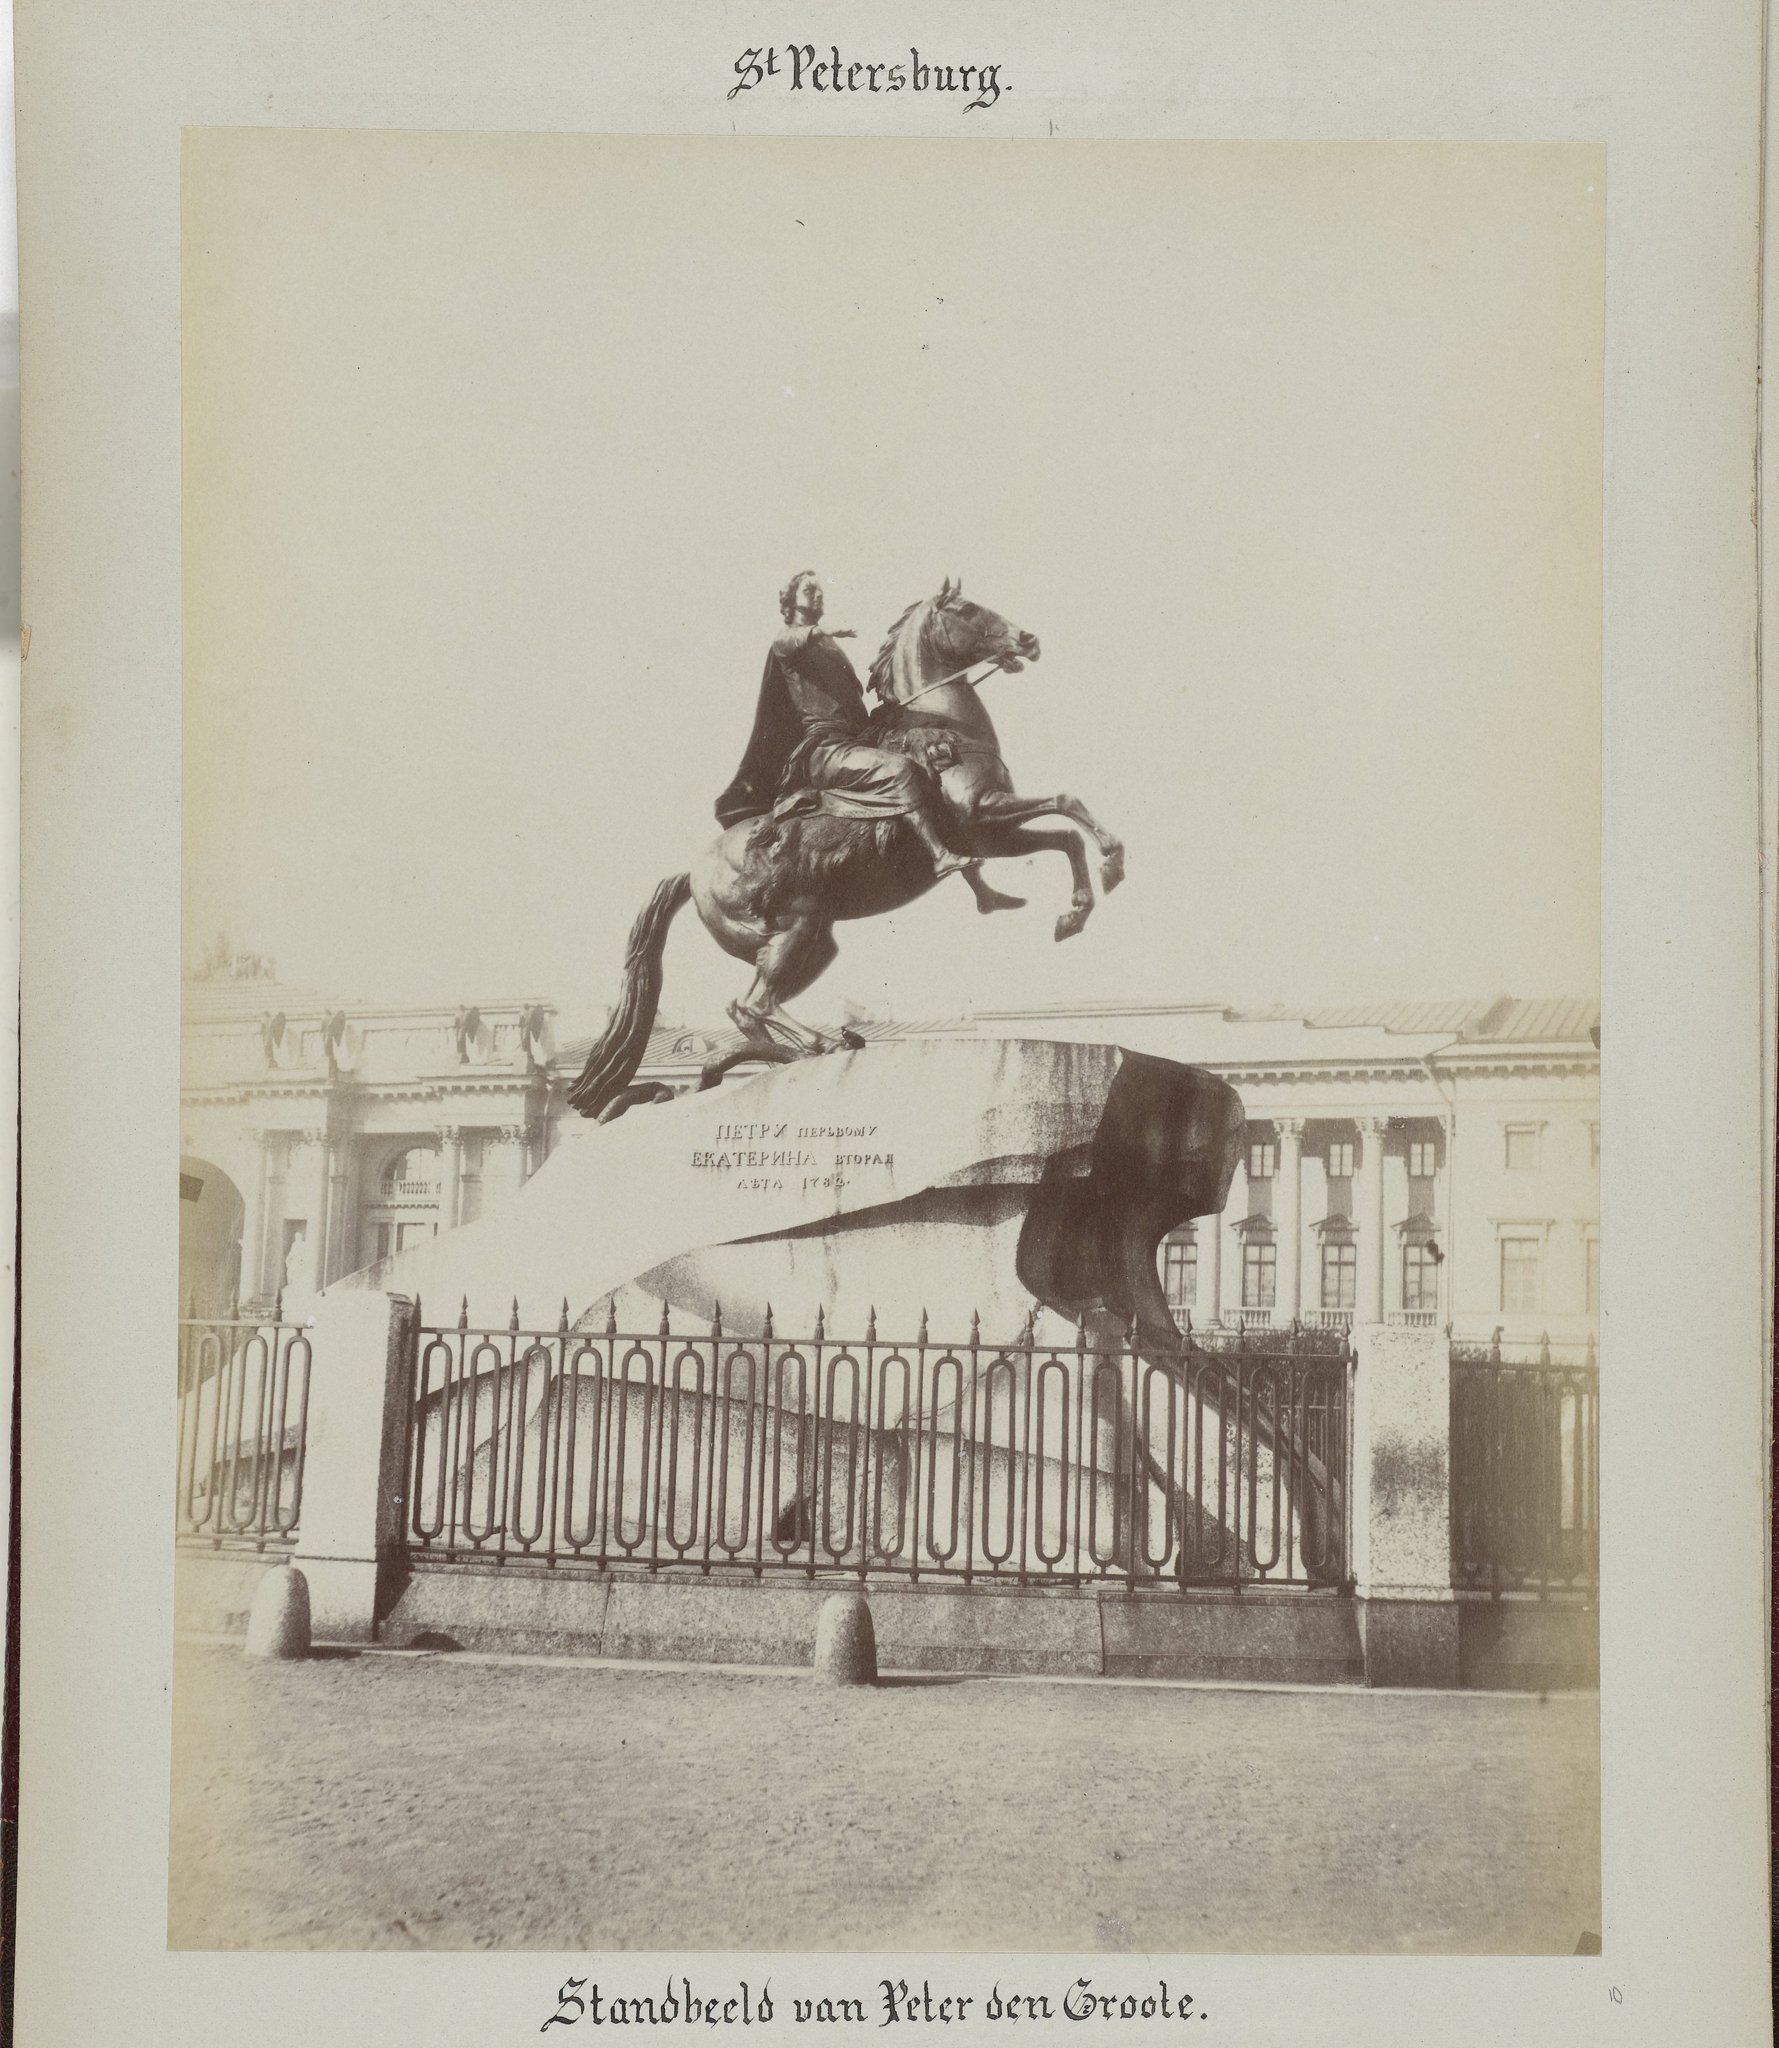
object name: photograph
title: St. Petersburg, standbeeld van Peter den Groote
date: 1898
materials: paper, photographic support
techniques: albumen print